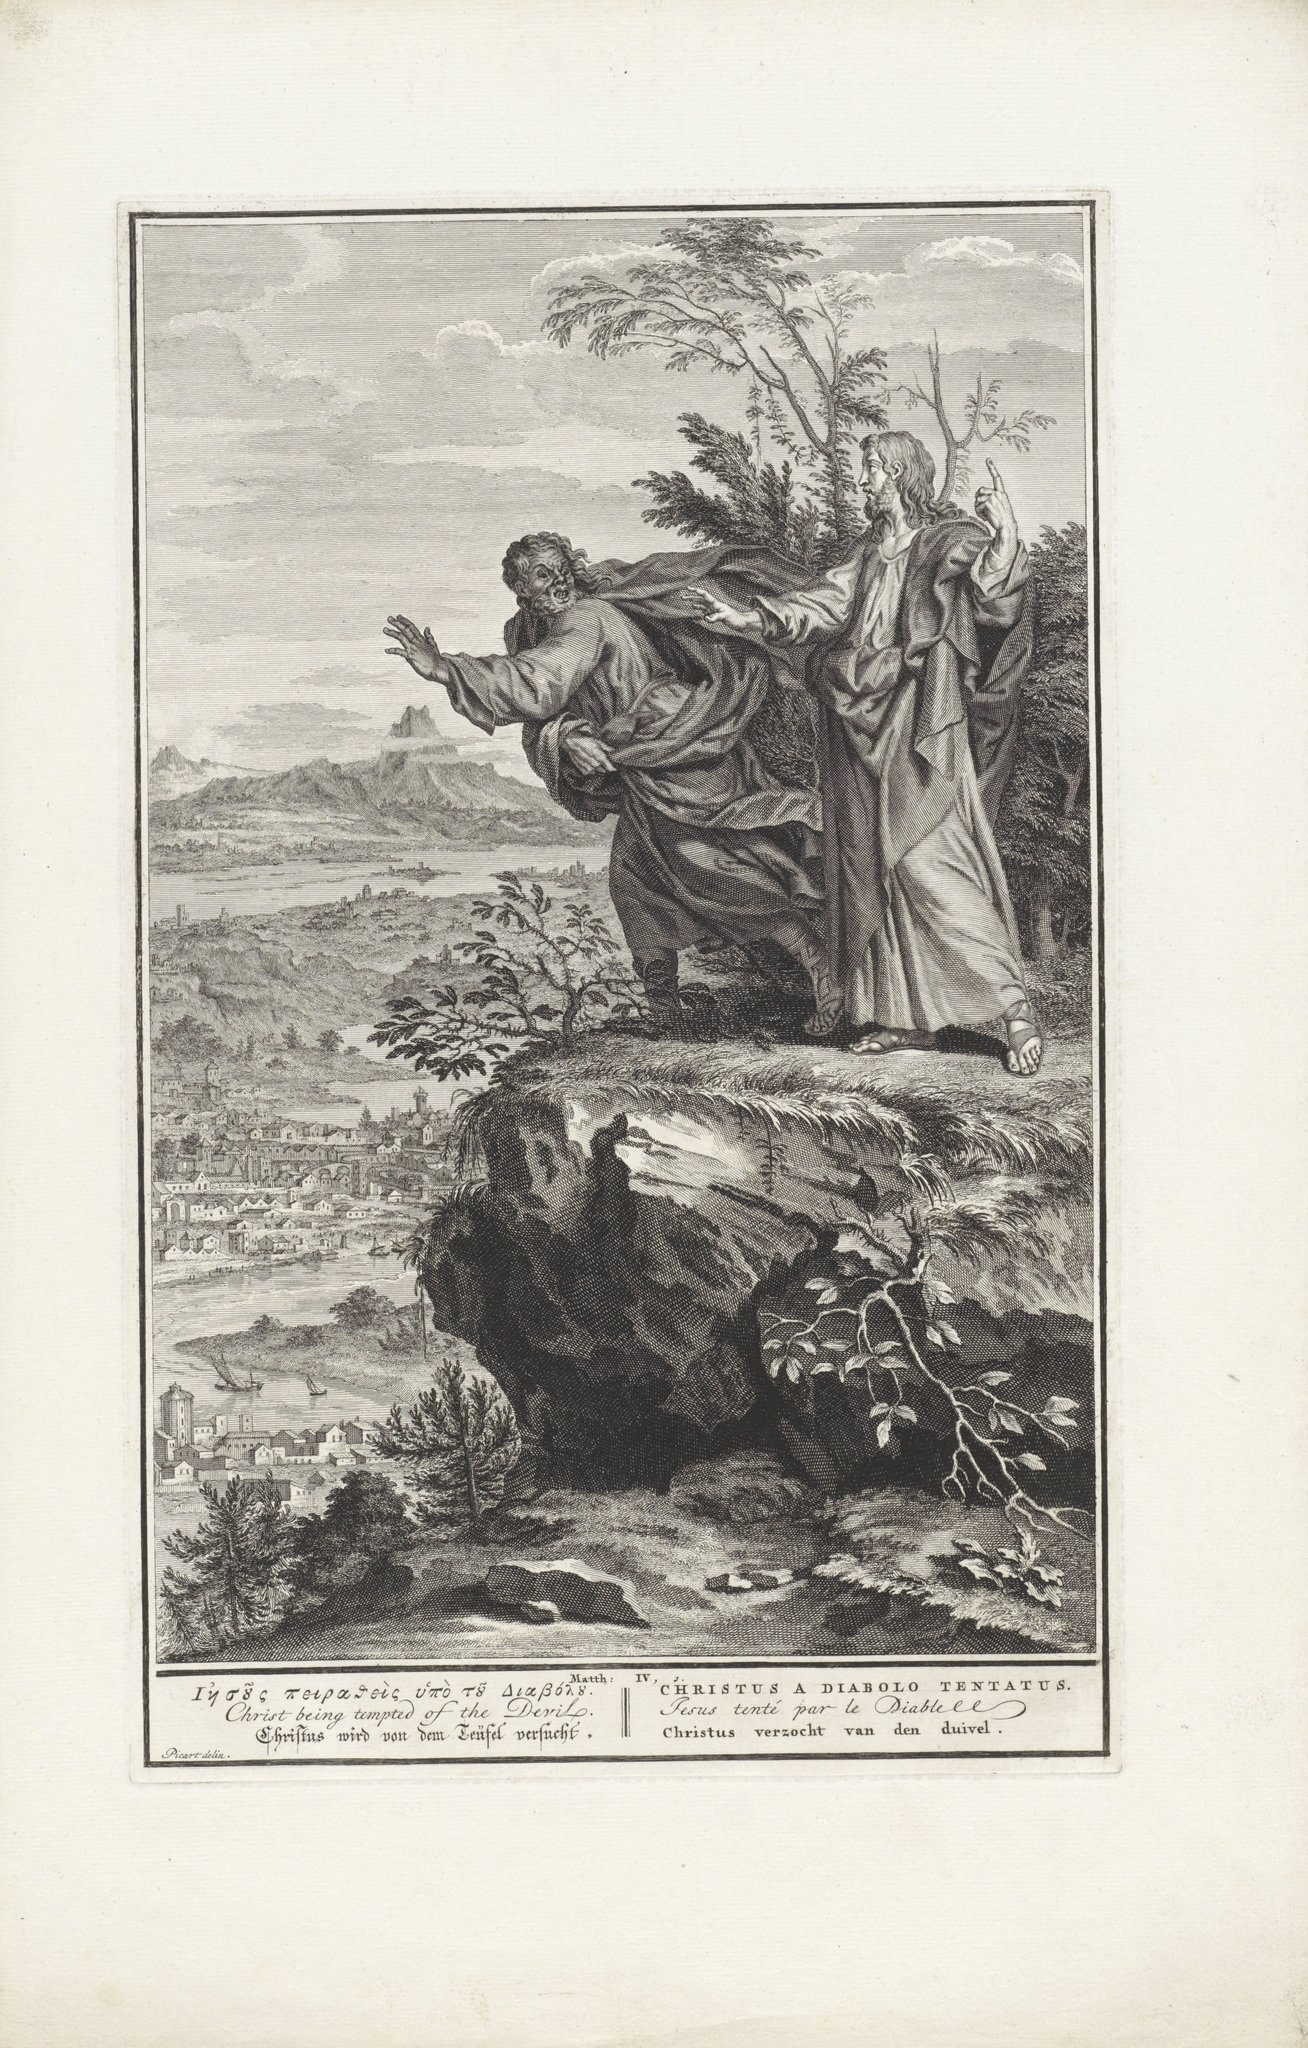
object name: print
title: Verzoeking van Christus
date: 1693-1783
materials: paper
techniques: engraving, etching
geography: low countries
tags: satan withdrawing from christ ~ temptation of christ in the wilderness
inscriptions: collector's mark: Lugt 2228, inscription: ‘Utrechts Fundatie huijs’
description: Christus staat op een rotsachtige heuvel. Naast hem Satan in de gedaante van een oude man, die zich woedend van Christus afwendt. Aan de voet van de heuvel ligt Jeruzalem. Onderaan een éénregelige titel in het Hebreeuws, Engels, Duits, Latijn, Frans en Nederlands uit Mat. 4.